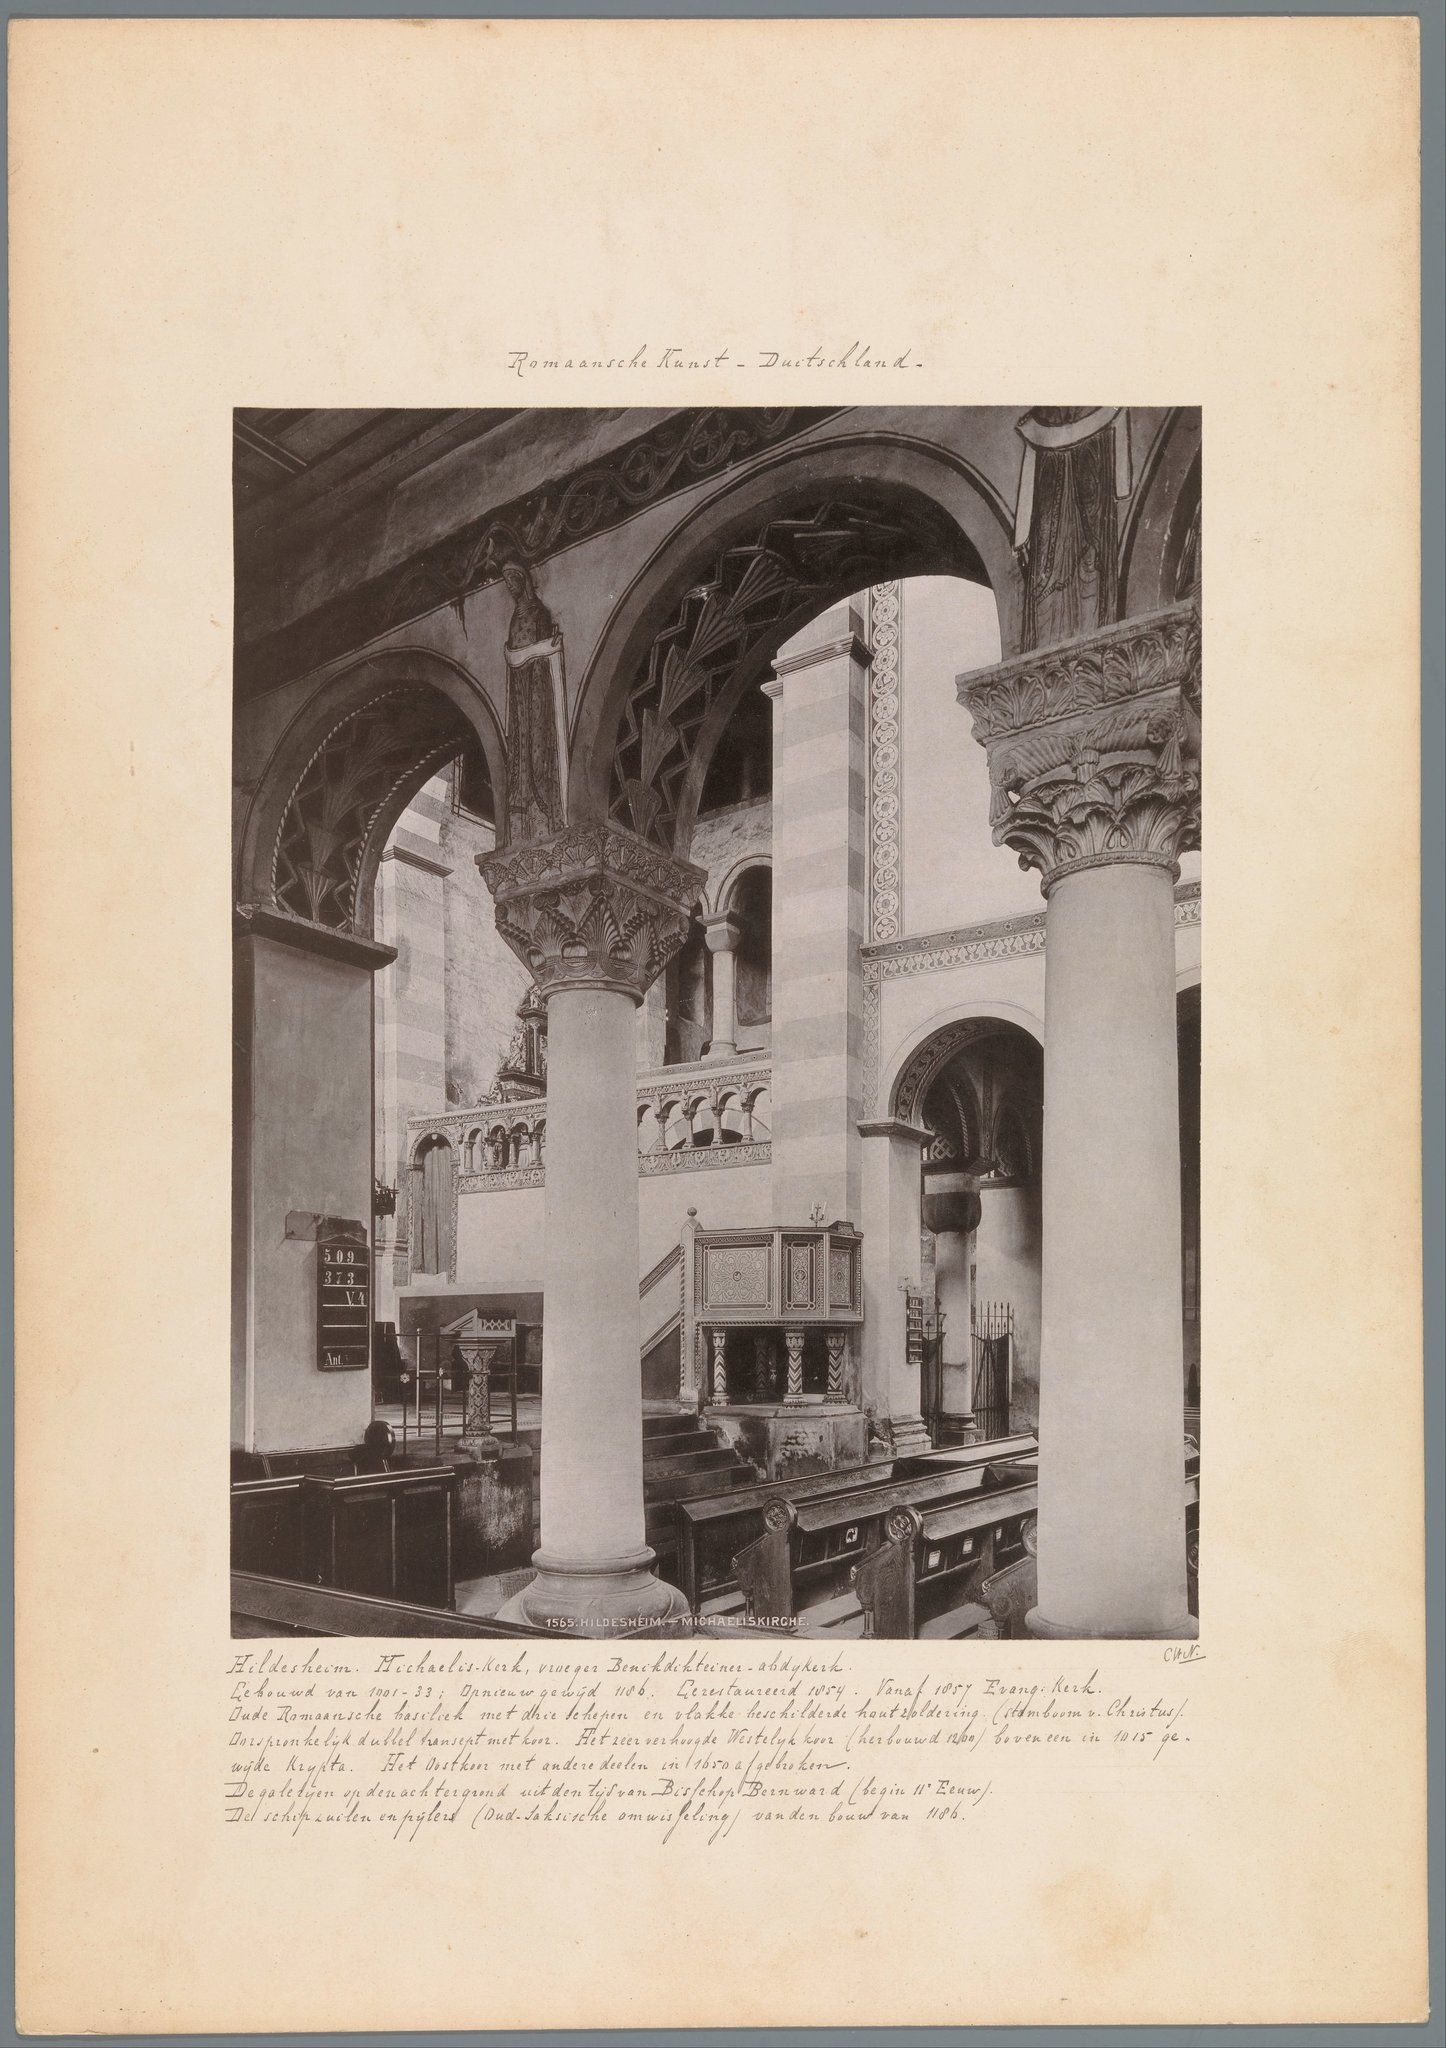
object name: photograph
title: Interieur van de Michaeliskirche te Hildesheim, met zicht op de preekstoel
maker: Anonymous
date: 1875-1900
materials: cardboard, paper, ink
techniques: photograph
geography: michaeliskirche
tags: column, pillar ~ architecture, interior of church, pulpit, ambo, chancel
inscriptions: collector's mark: ‘KUNSTNIJVERHEIDSCHOOL QUELLINUS AMSTERDAM FRANS HALSSTRAAT 14.’, inscription: ‘Romaansche Kunst - Duitschland. Hildesheim. (...) De schipzuilen en pijlers (Oud-Saksische omwisseling) van den bouw van 1186.’, number: ‘1565.’, collector's mark: ‘INSTITUUT VOOR KUNST- NIJVERHEIDSONDERWIJS GABRIËL METSUSTRAAT No. 16. AMSTERDAM’, inscription: ‘CWN.’